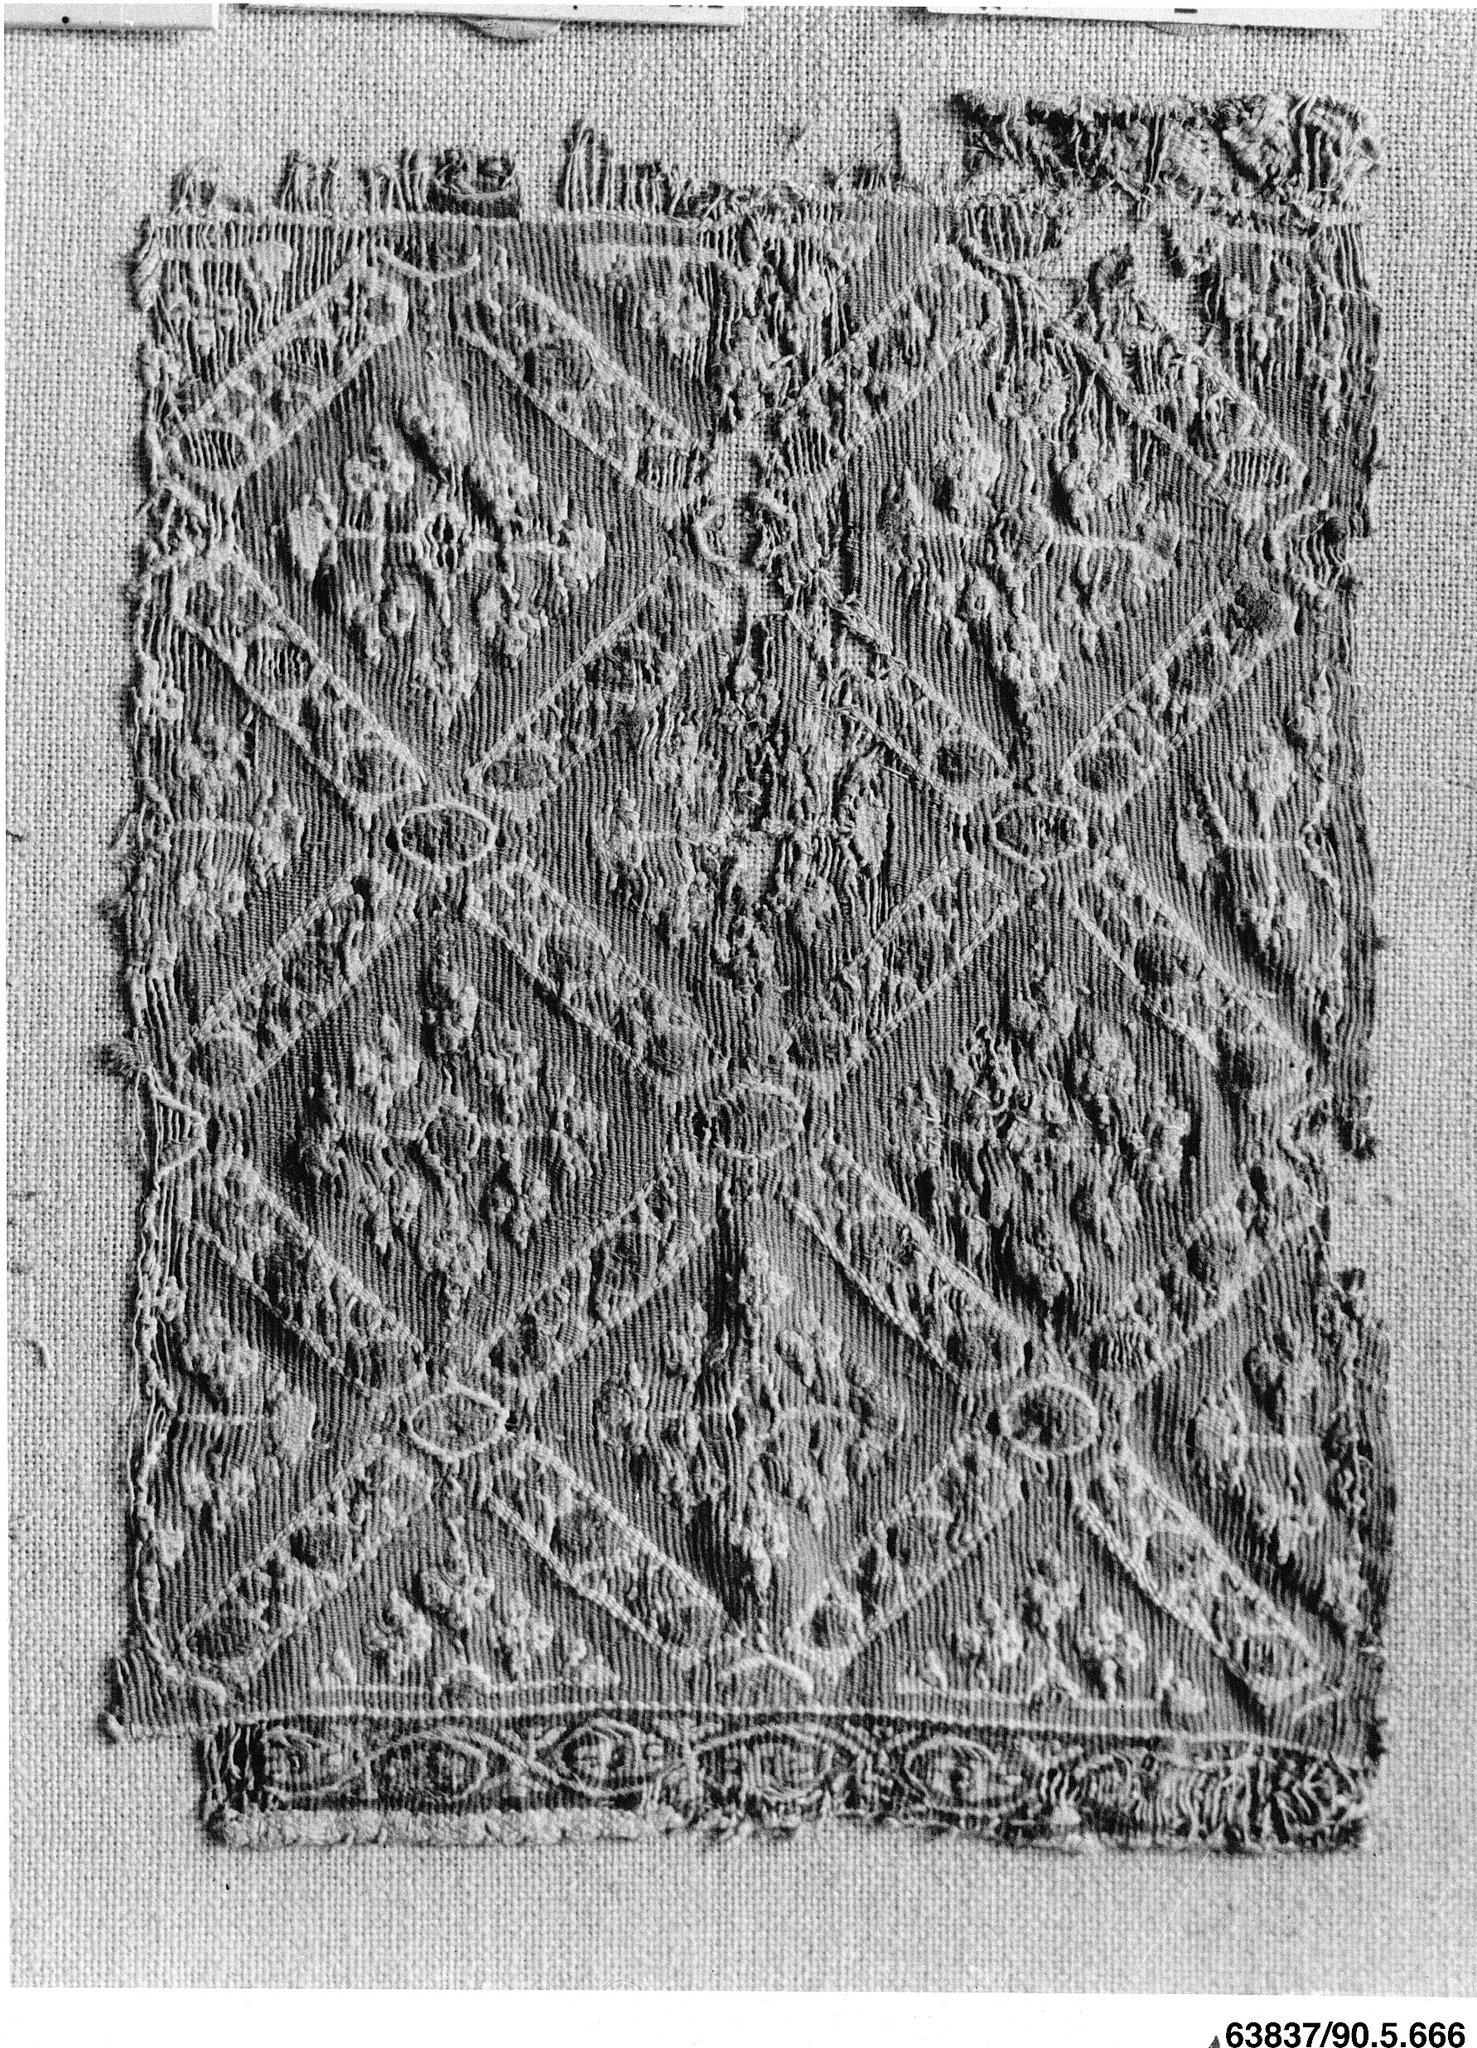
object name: textile fragment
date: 501-700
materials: linen, wool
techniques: weave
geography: egypt